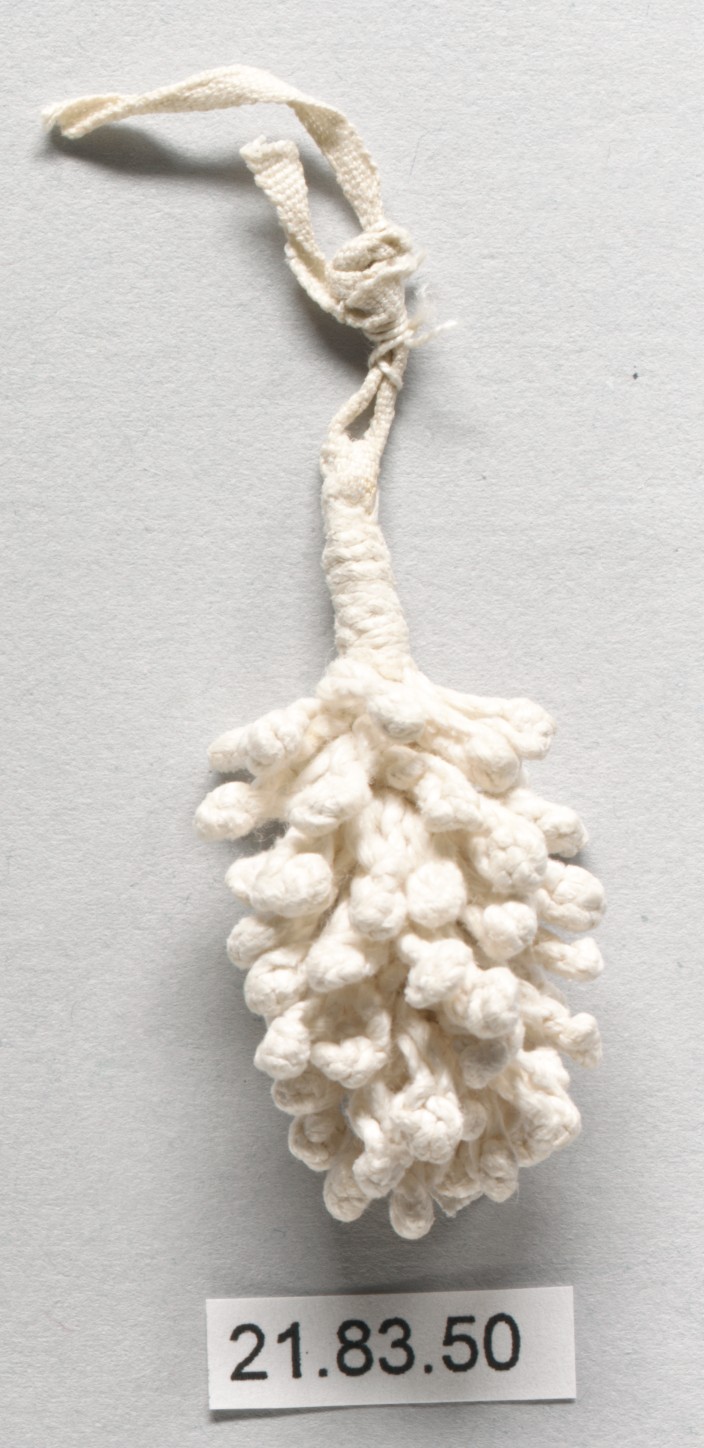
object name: tassel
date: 1601-1700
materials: linen